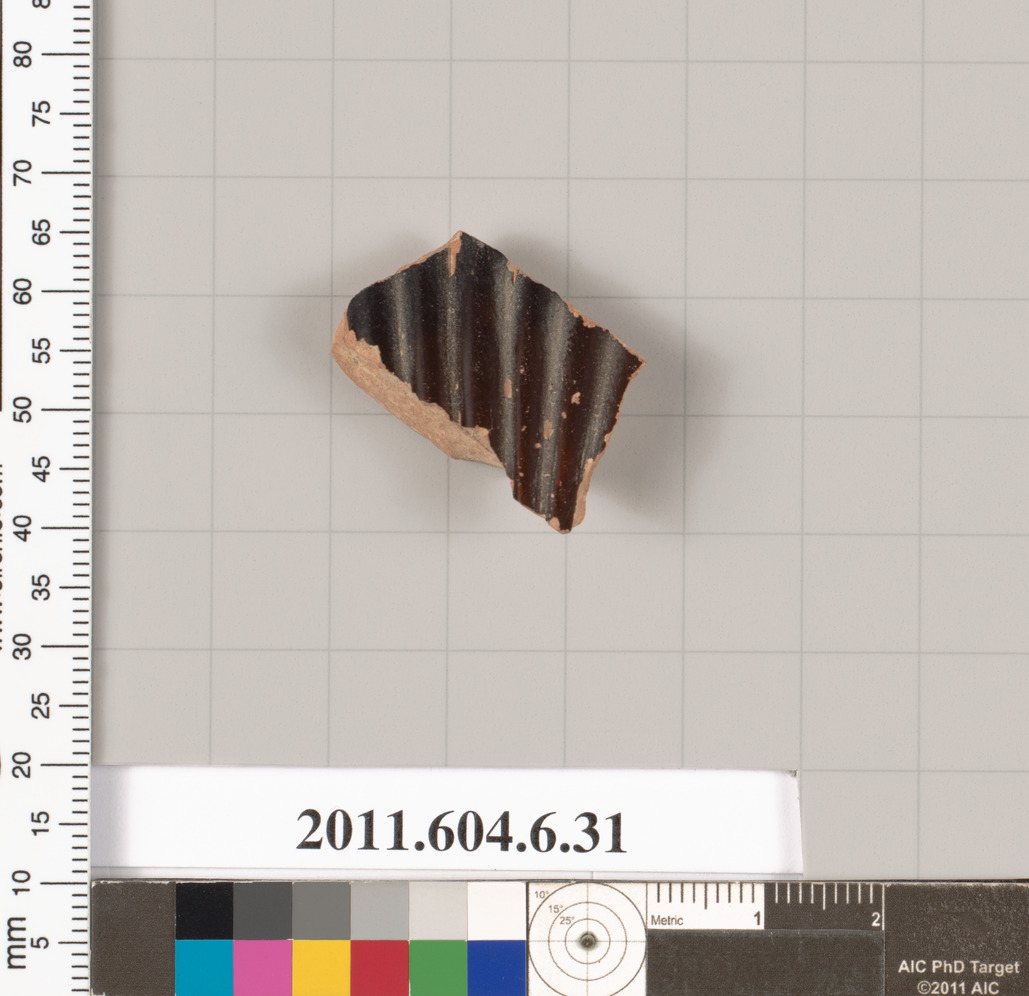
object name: undetermined open shape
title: Terracotta fragment of an open shape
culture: greek, attic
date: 375-351 BCE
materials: terracotta